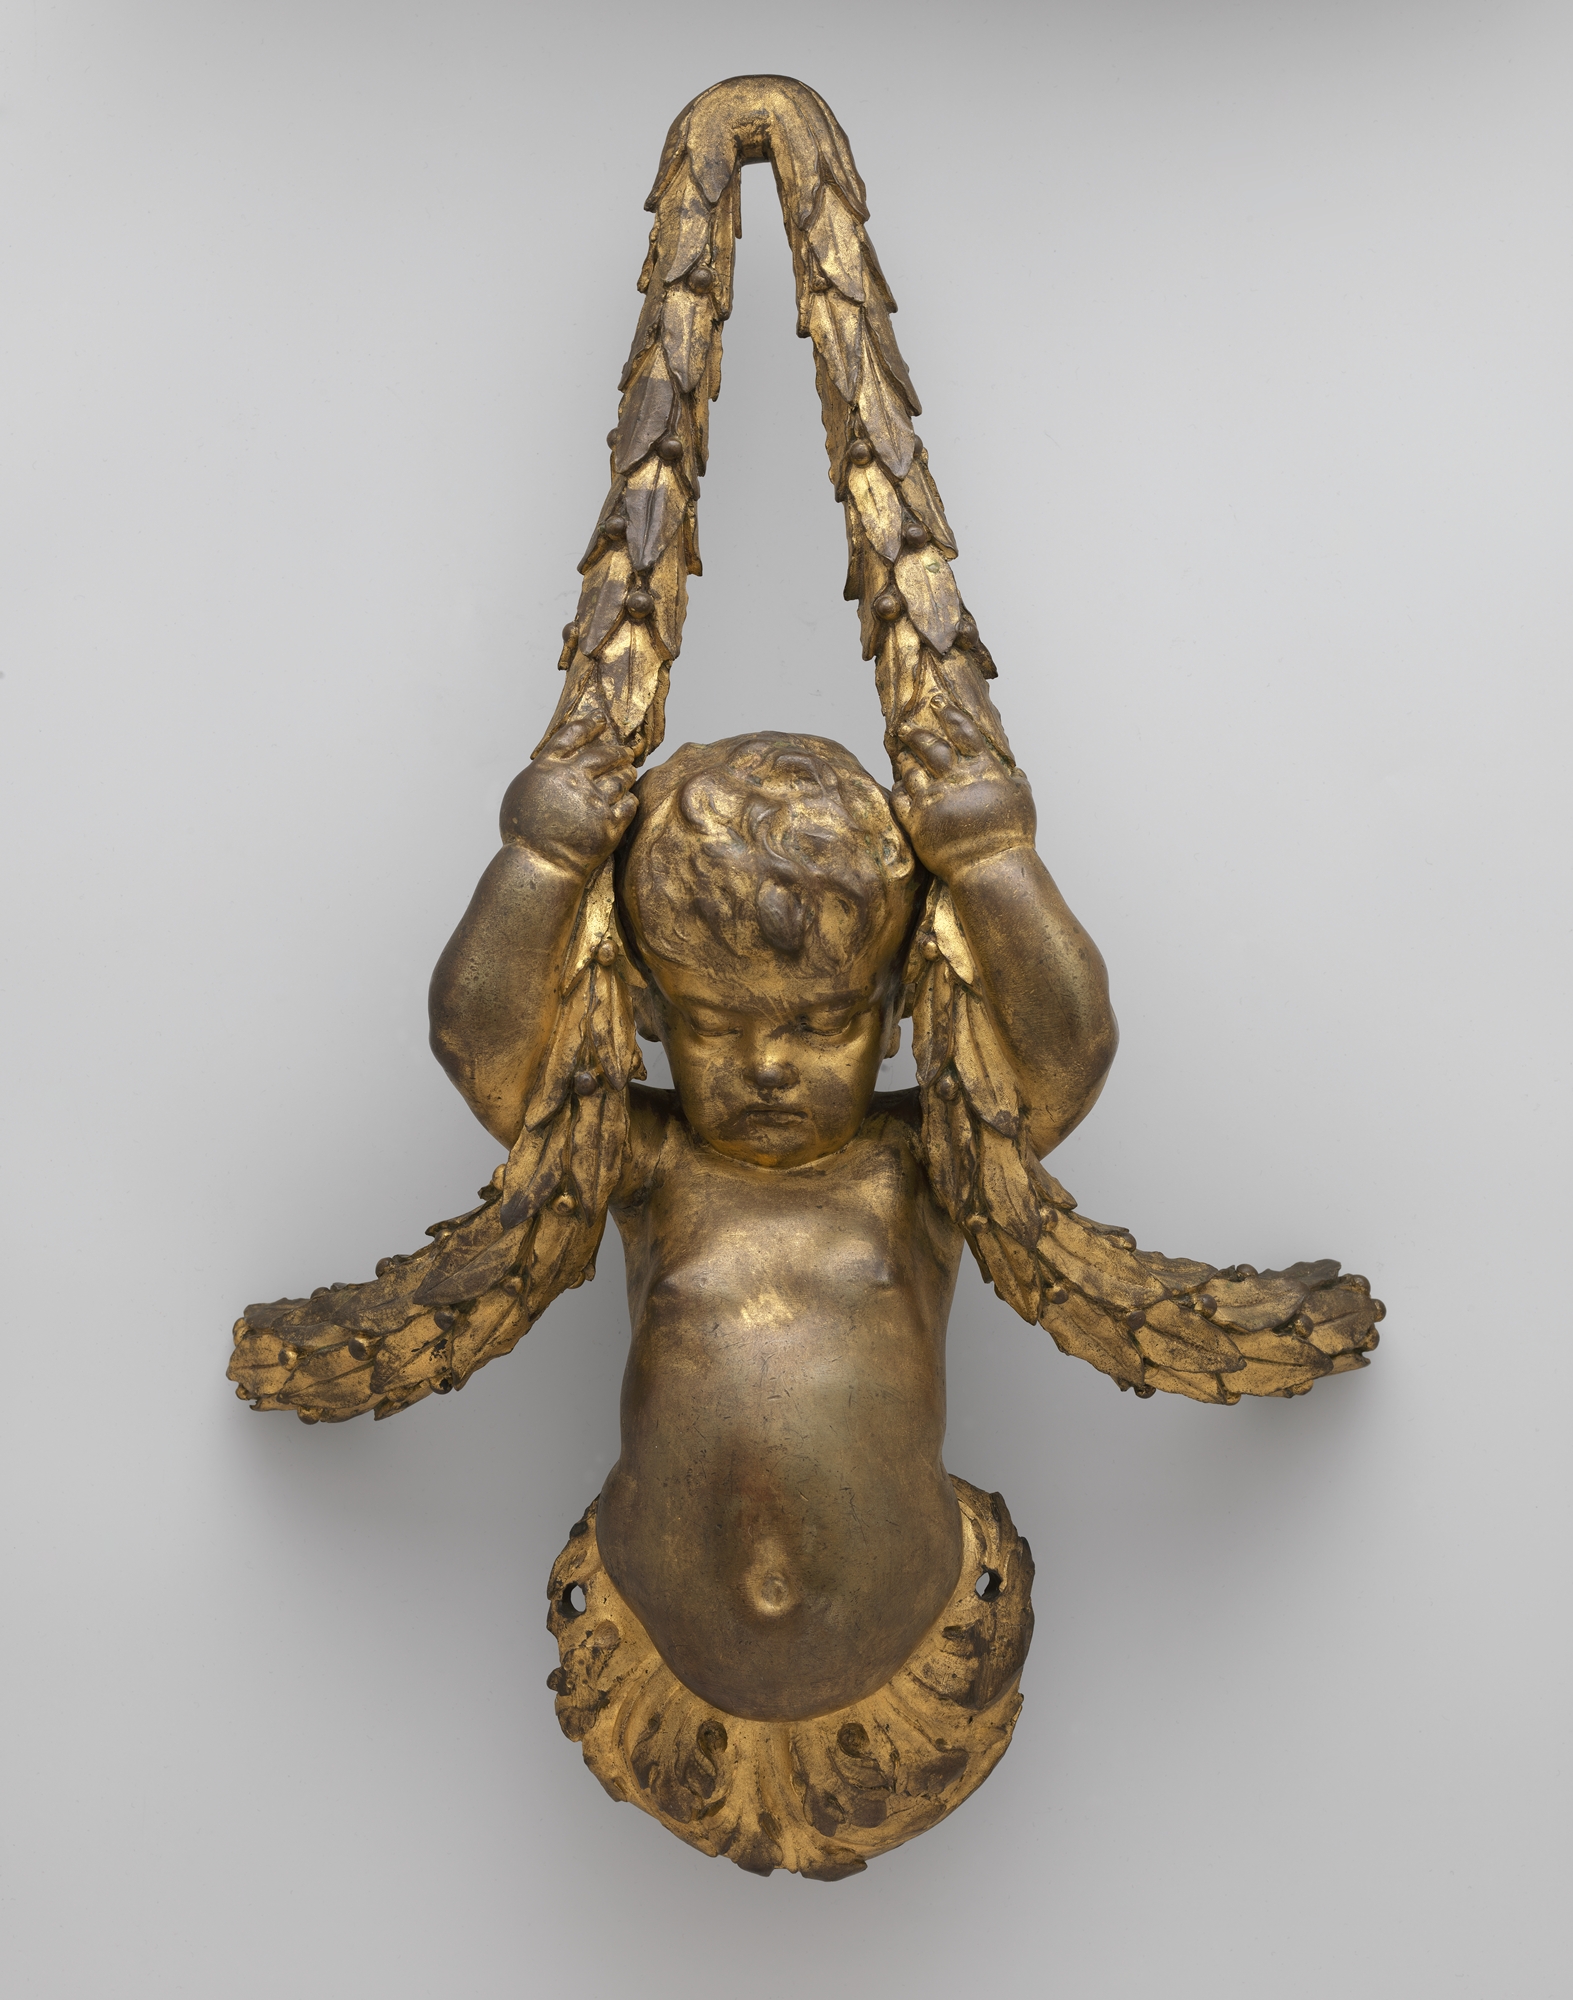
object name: vase ornament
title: Vase ornament (?)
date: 1701-1800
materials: gilt bronze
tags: children